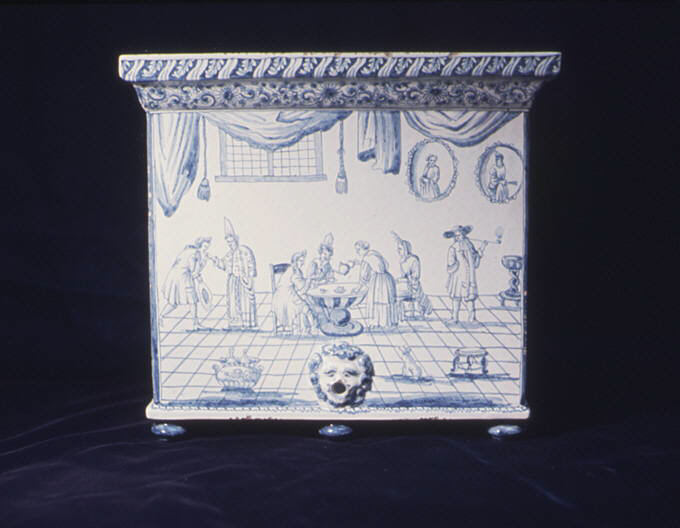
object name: cistern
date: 1801-1900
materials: earthenware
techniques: glazing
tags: men,women